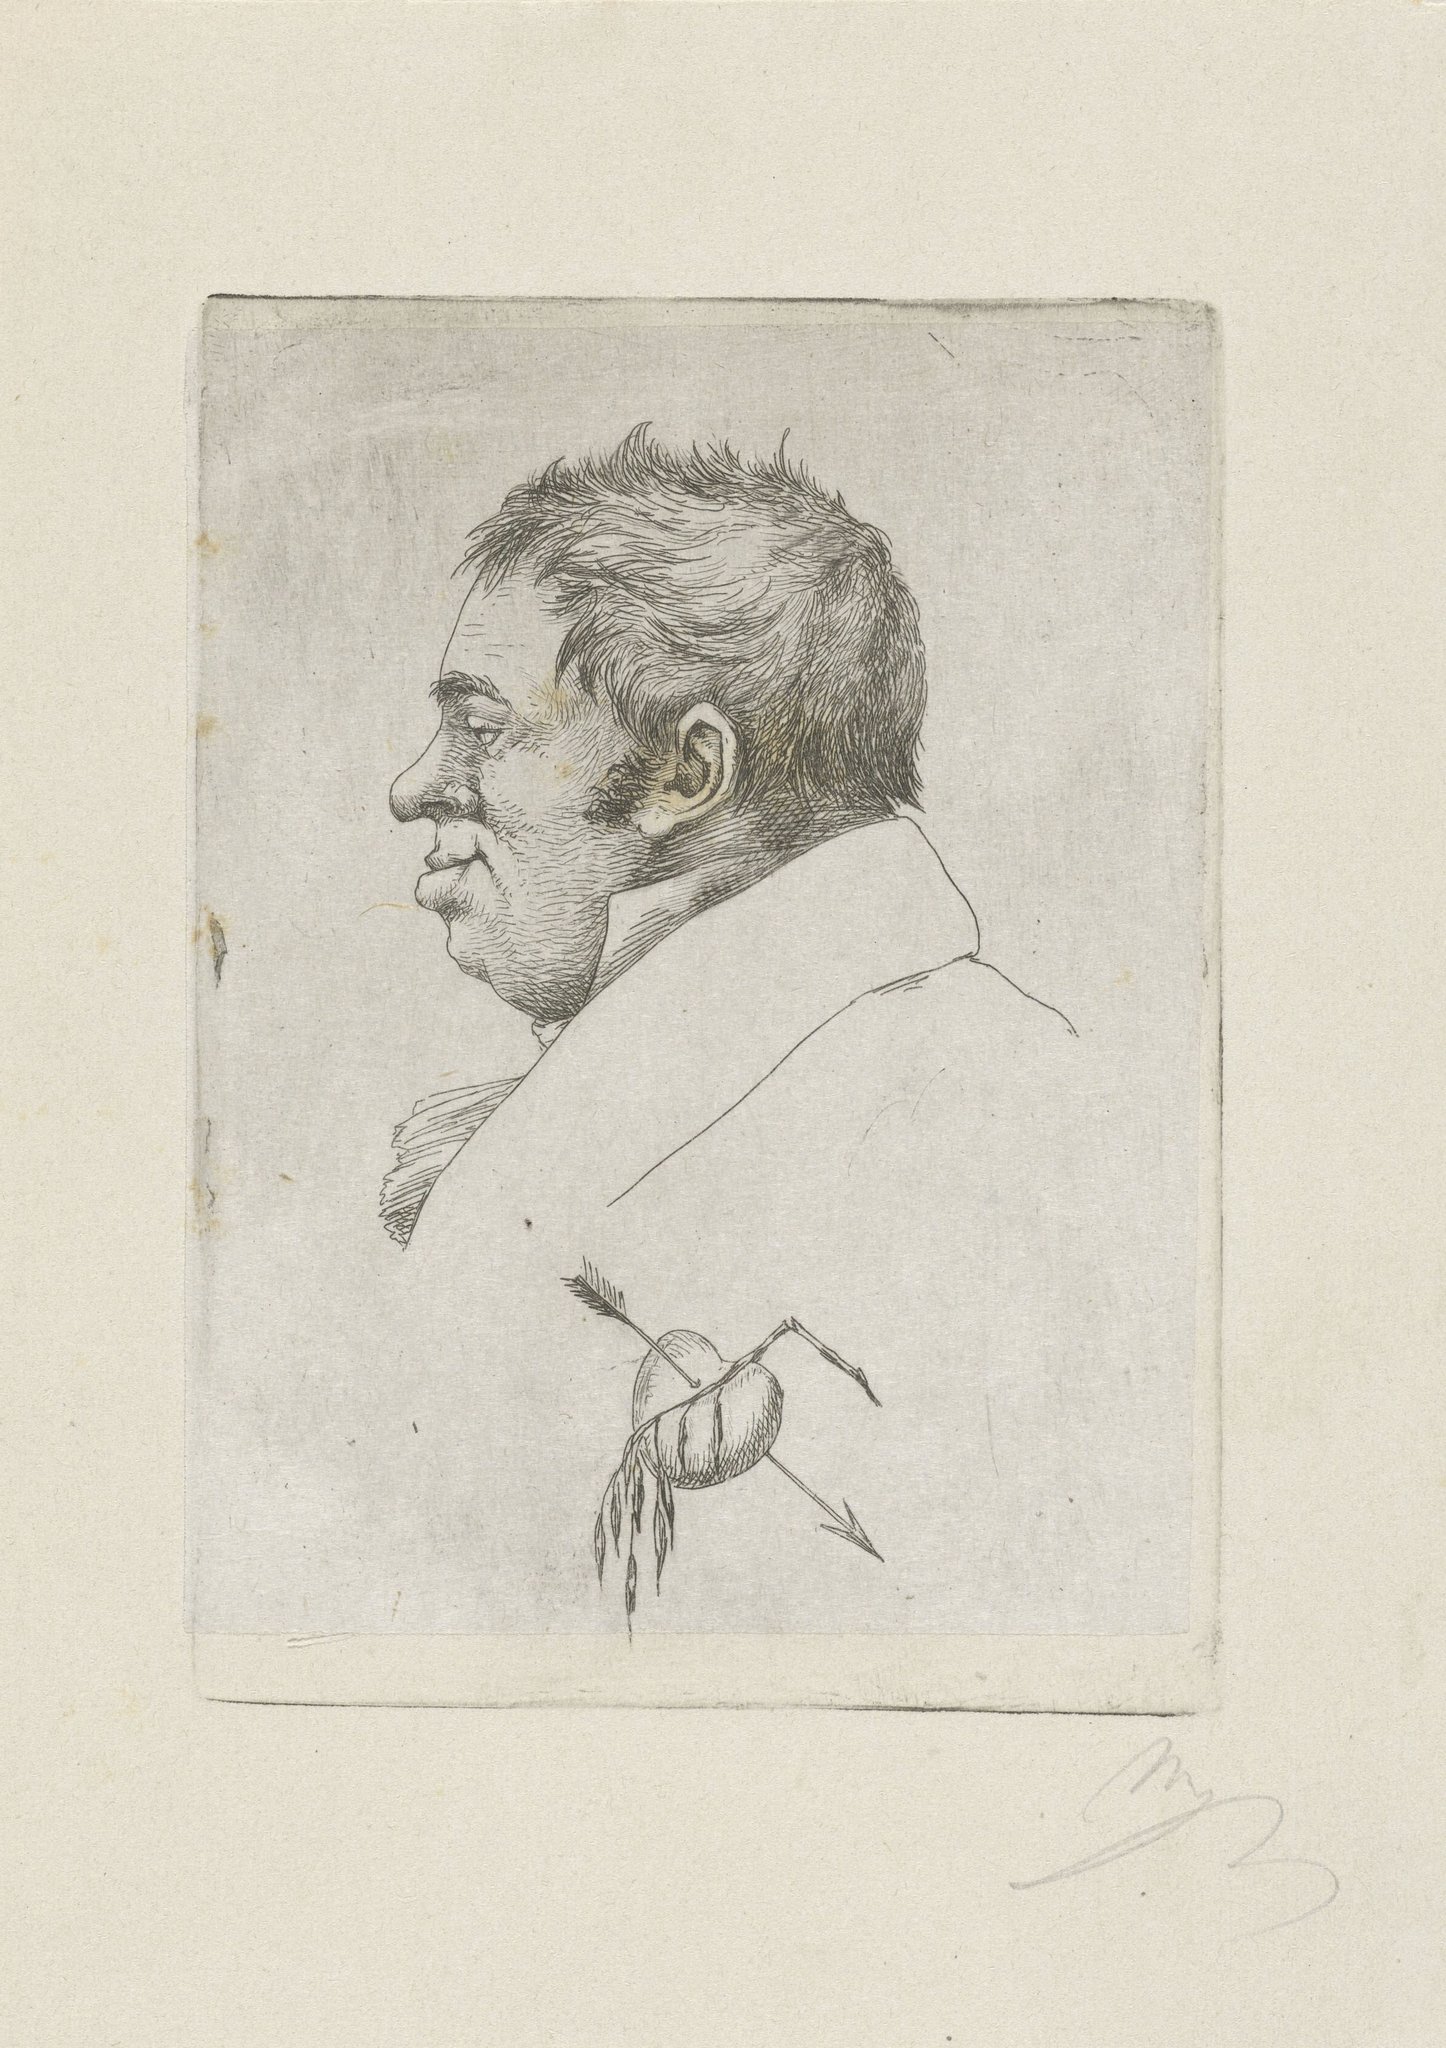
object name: print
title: Portret van Jantje de Wit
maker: jean zacherie mazel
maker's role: draughtsman, print maker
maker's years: 1792-1884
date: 1802-1884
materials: paper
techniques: etching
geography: netherlands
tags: heart symbolism, archer's weapons: arrow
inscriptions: inscription: ‘Jantje de Wit - oudliefhebber / notaris te Amsterdam / geteekend aan table d'hote in het Rondiel’, collector's mark: Lugt 2228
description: Portret van Jantje de Wit, notaris te Amsterdam, en profil. Midden onder een met pijl doorstoken hart en een geknakte tak met hangende bladeren.